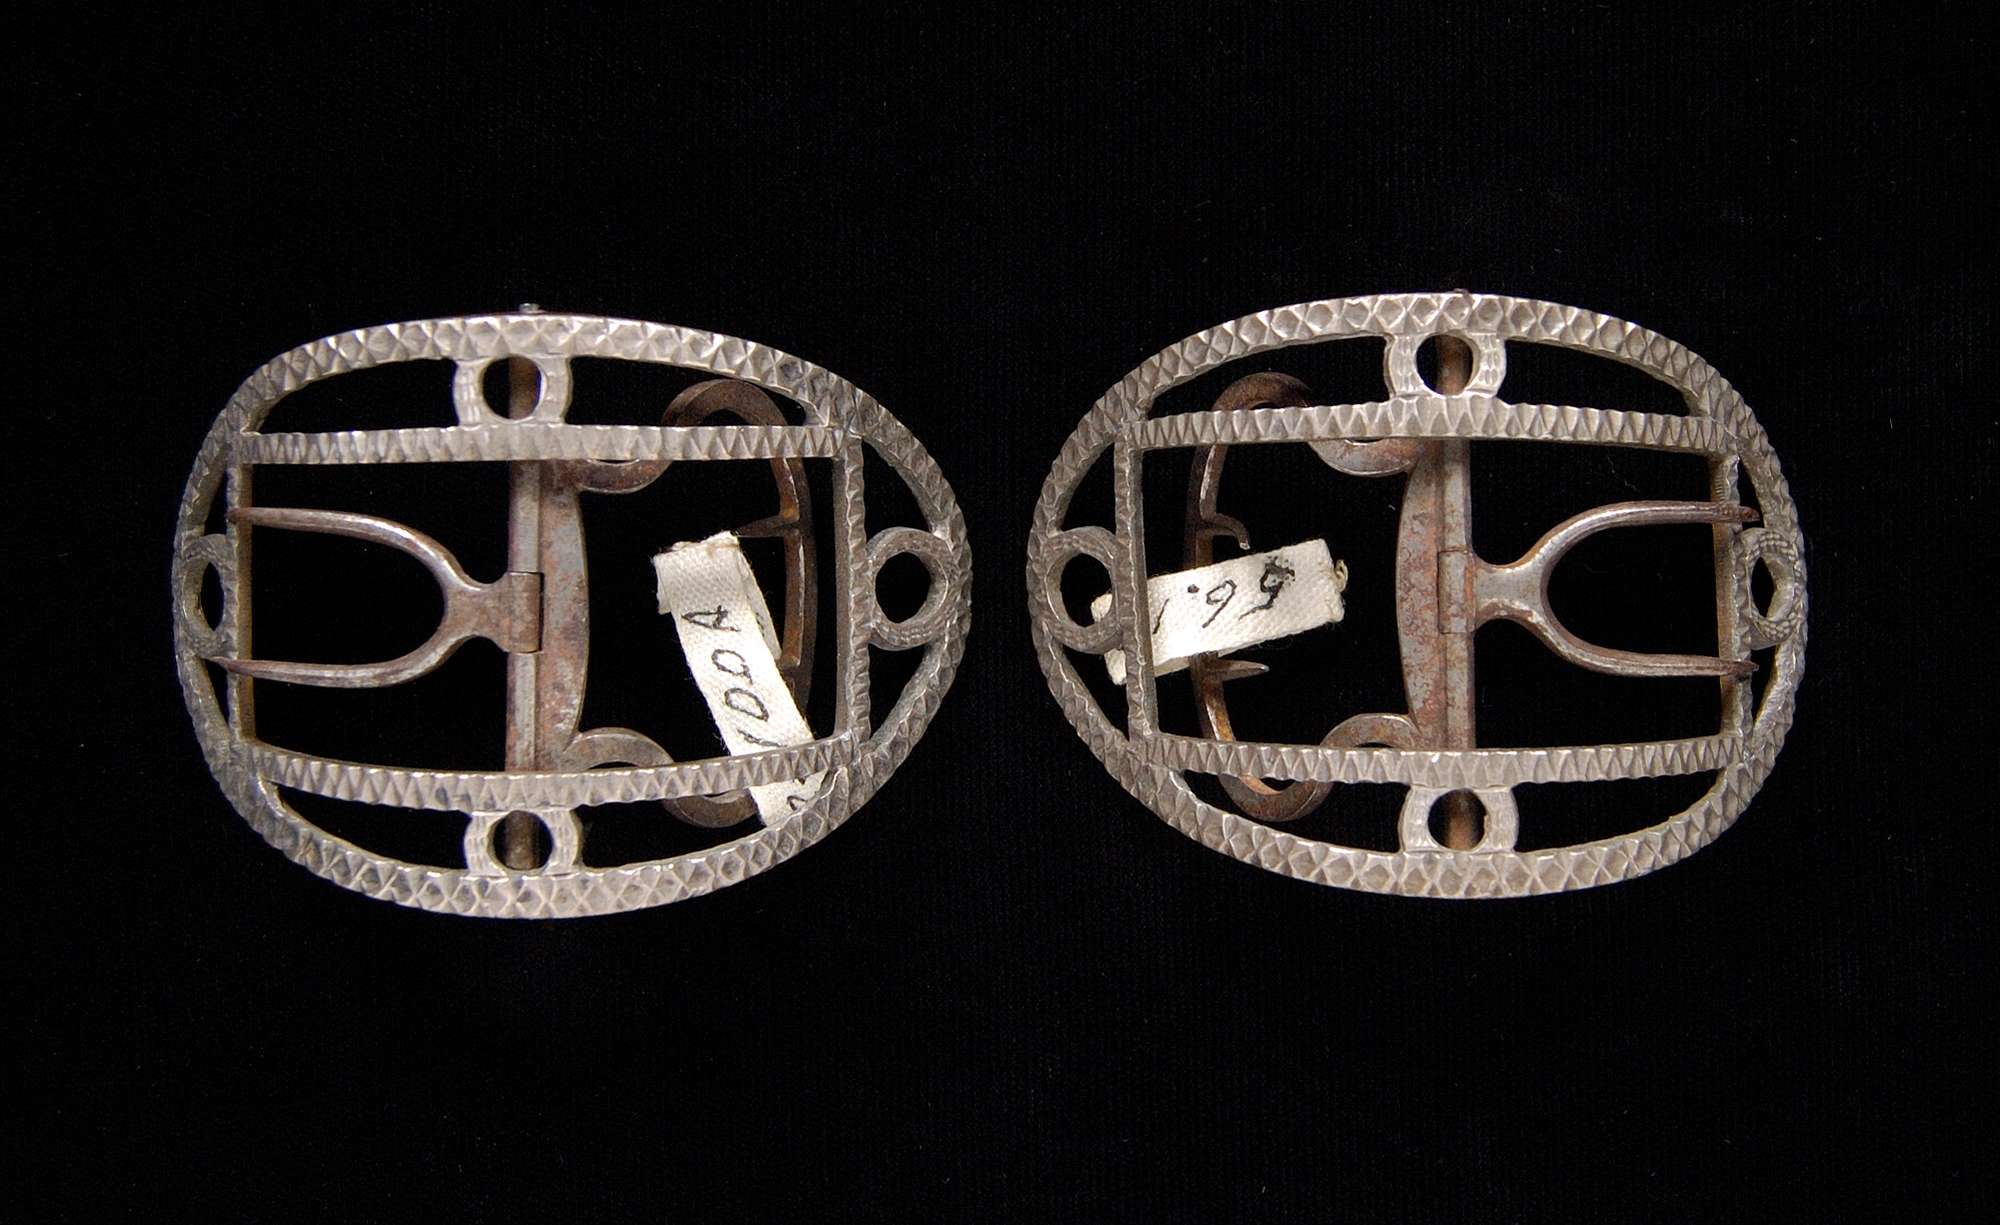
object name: shoe buckle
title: Shoe buckles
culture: british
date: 1770-1790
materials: metal